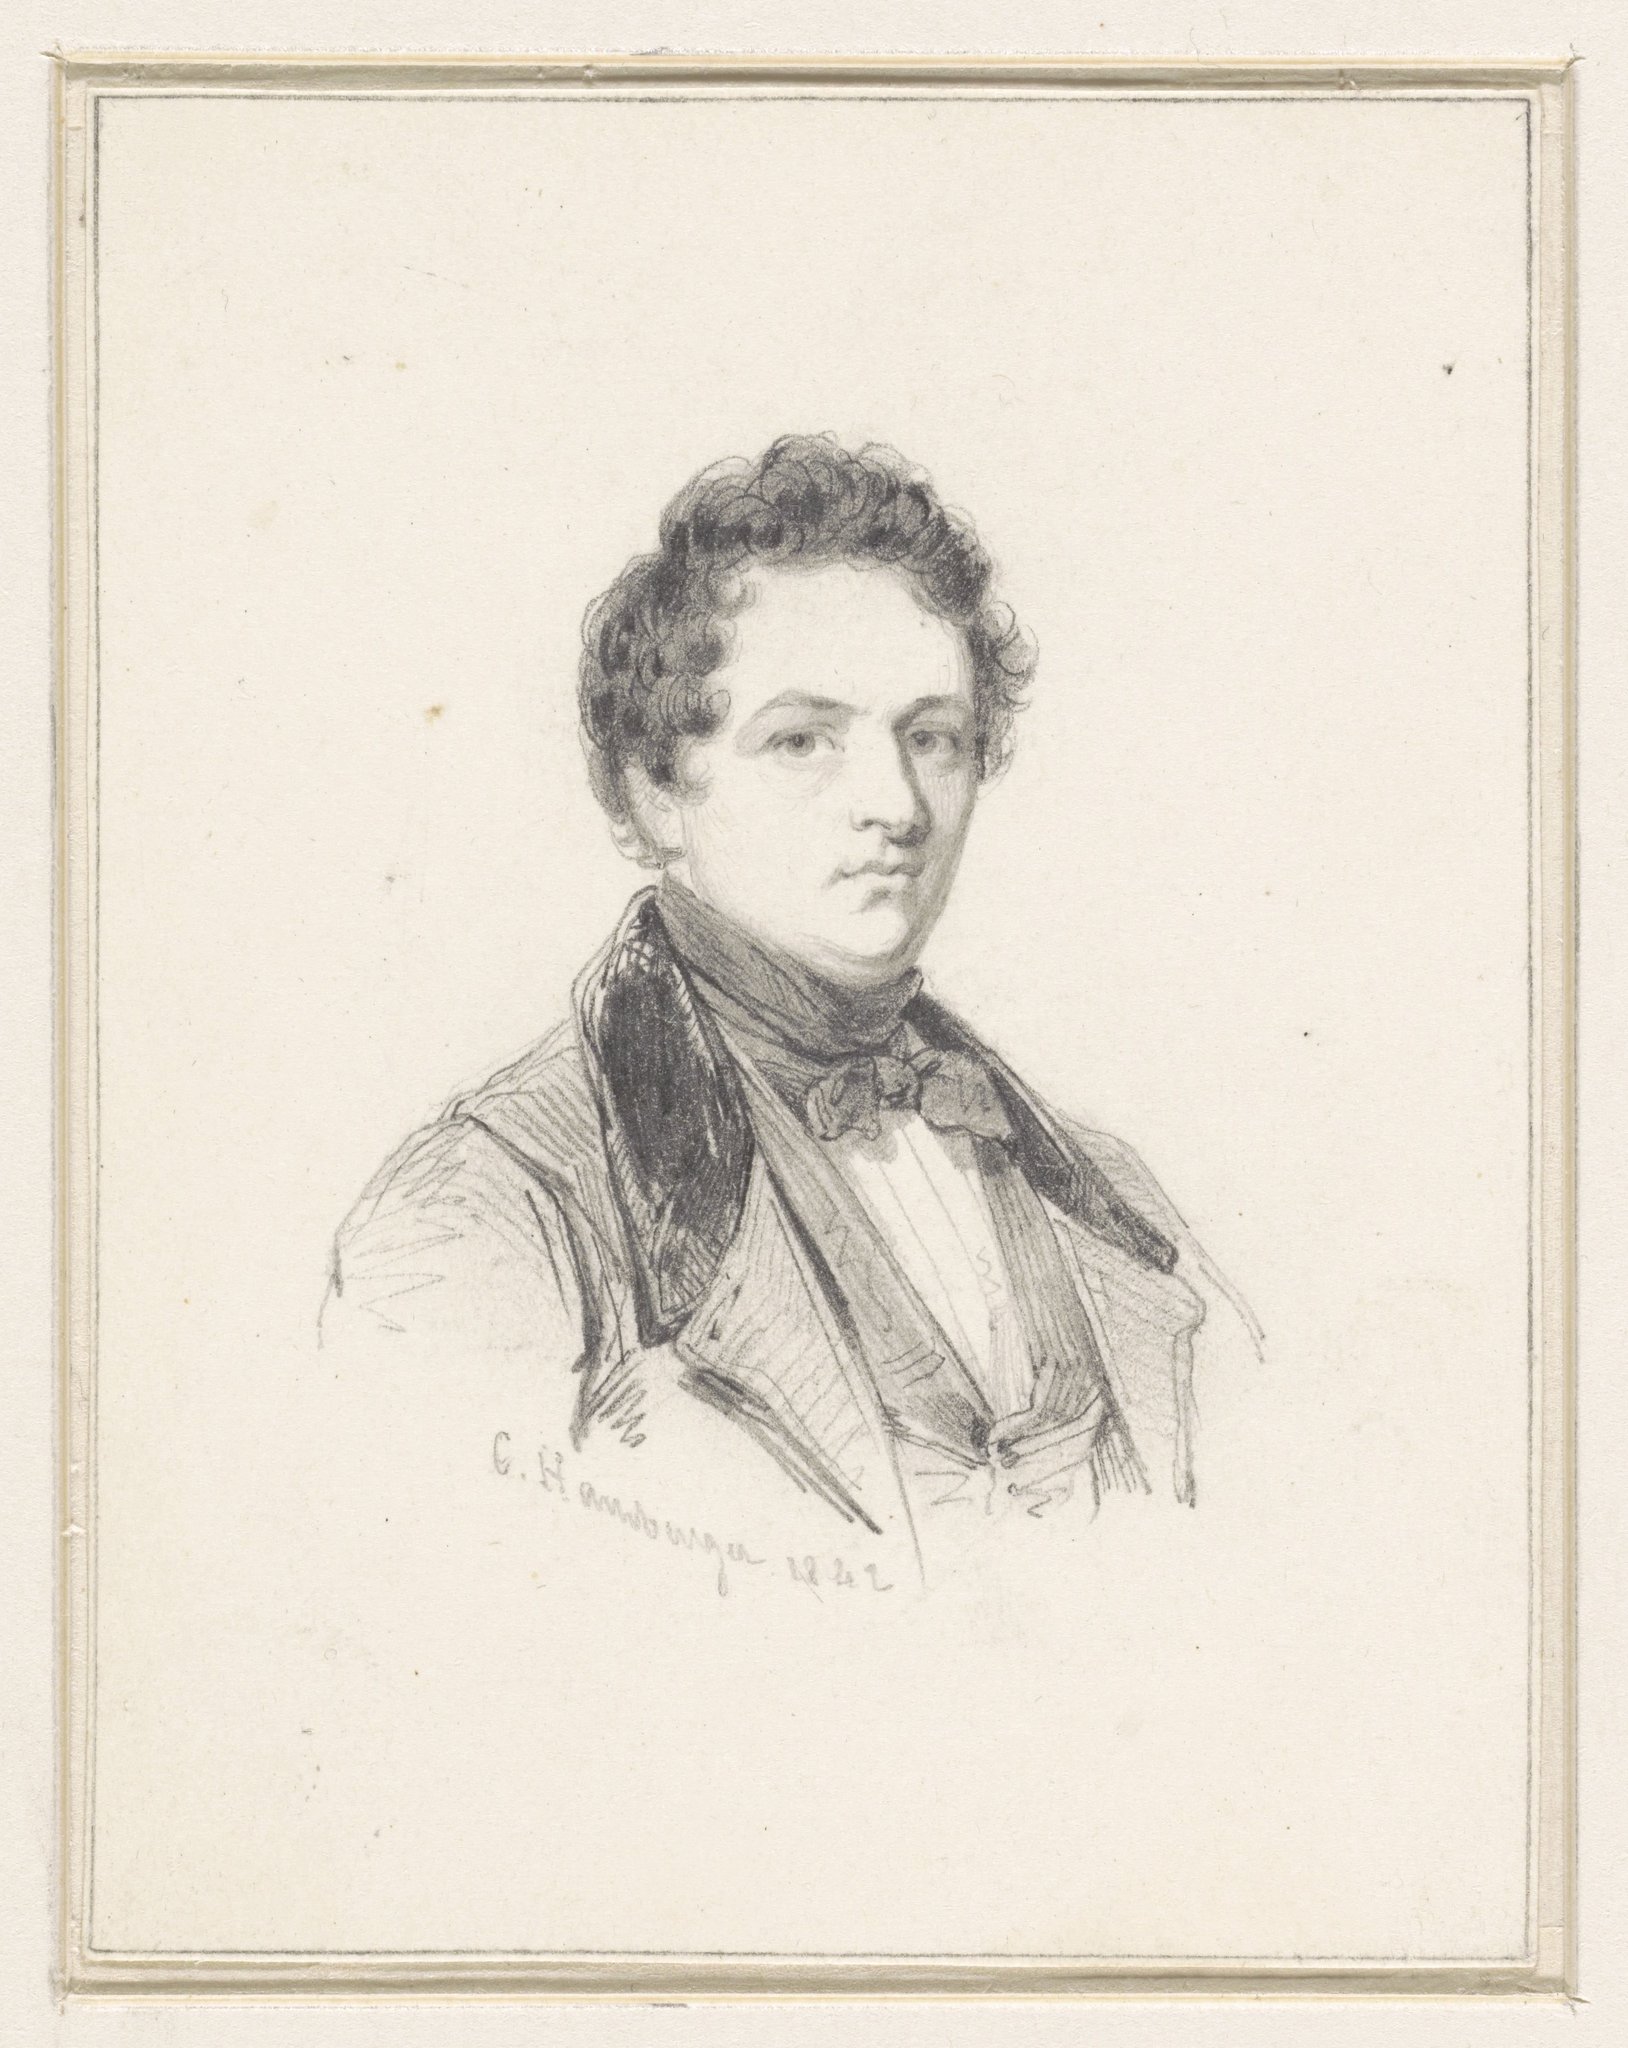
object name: drawing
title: Portret van Hubertus van Hove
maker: coenraad hamburger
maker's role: draughtsman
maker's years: 1809-1891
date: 1842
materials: paper, pencil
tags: print maker, hubertus van hove, historical persons, portrait, self-portrait of painter, portrait, self-portrait of artist, portrait, self-portrait of draughtsman